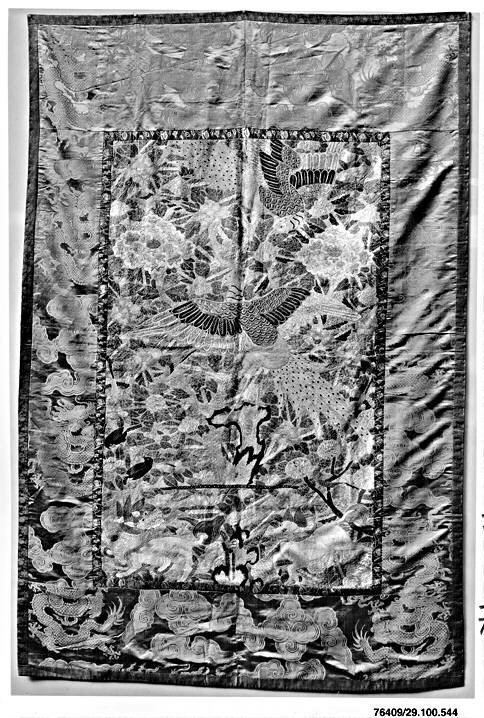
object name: panel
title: Vertical panel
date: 1501-1600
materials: metal thread, silk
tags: birds,flowers